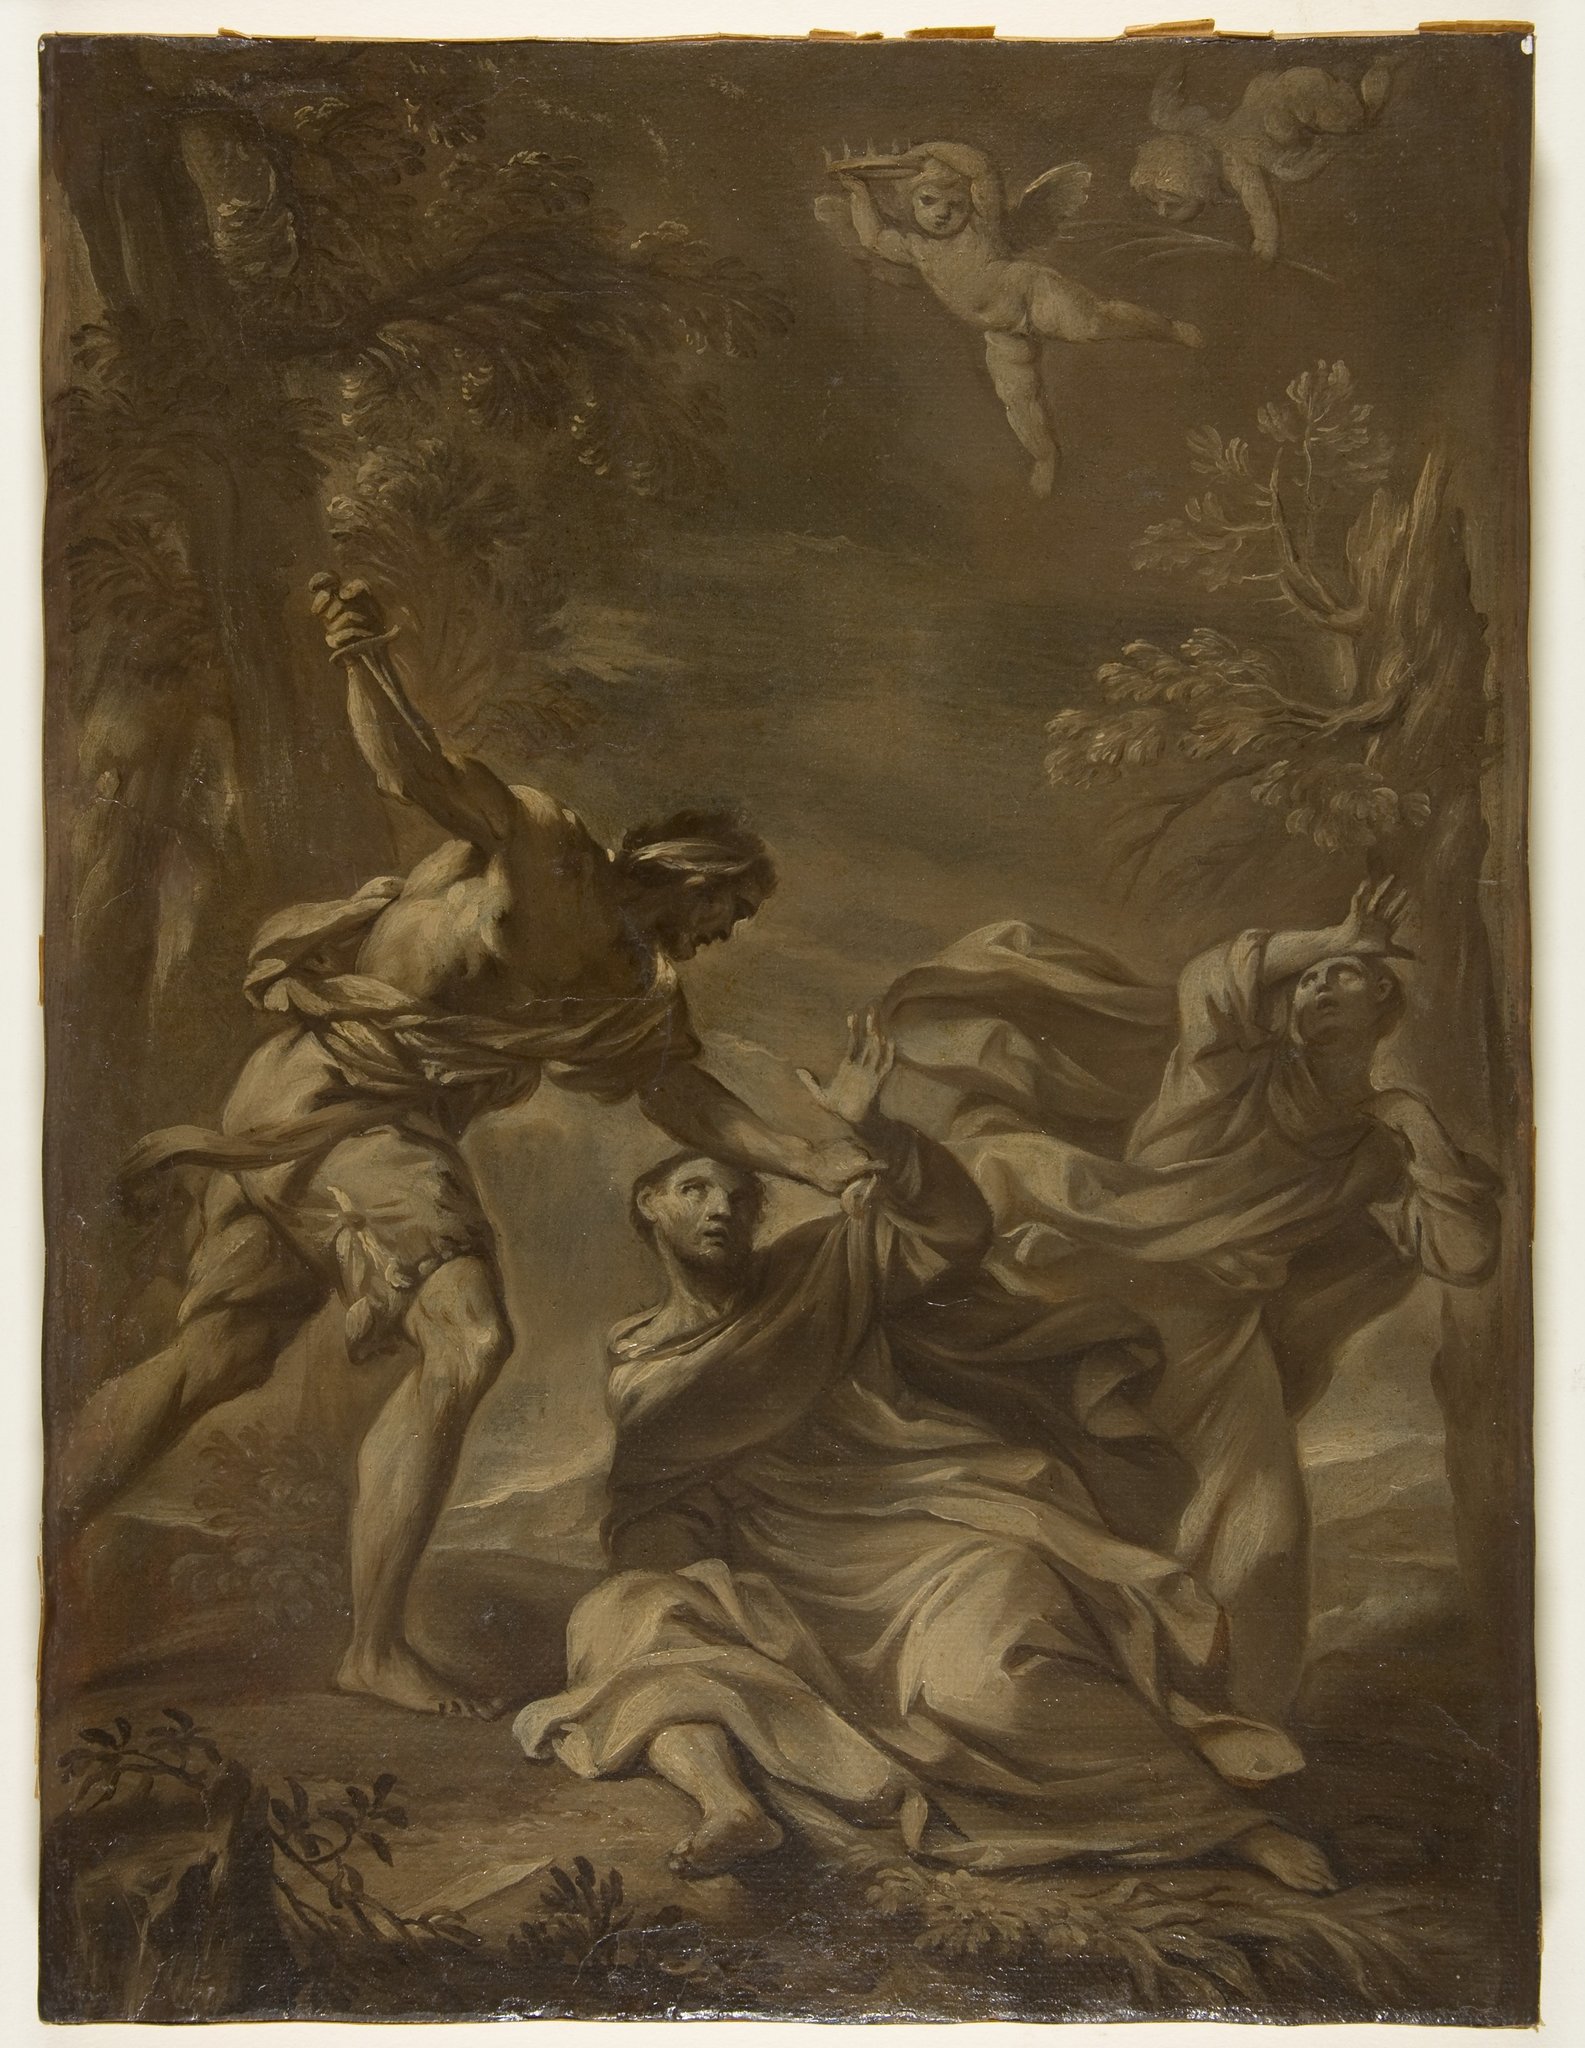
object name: drawing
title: Death of Saint Peter Martyr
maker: felice torelli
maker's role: artist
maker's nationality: italian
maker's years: 1667-1748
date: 1667-1748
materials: canvas, oil, paper, varnish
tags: suffering,putti,saint peter